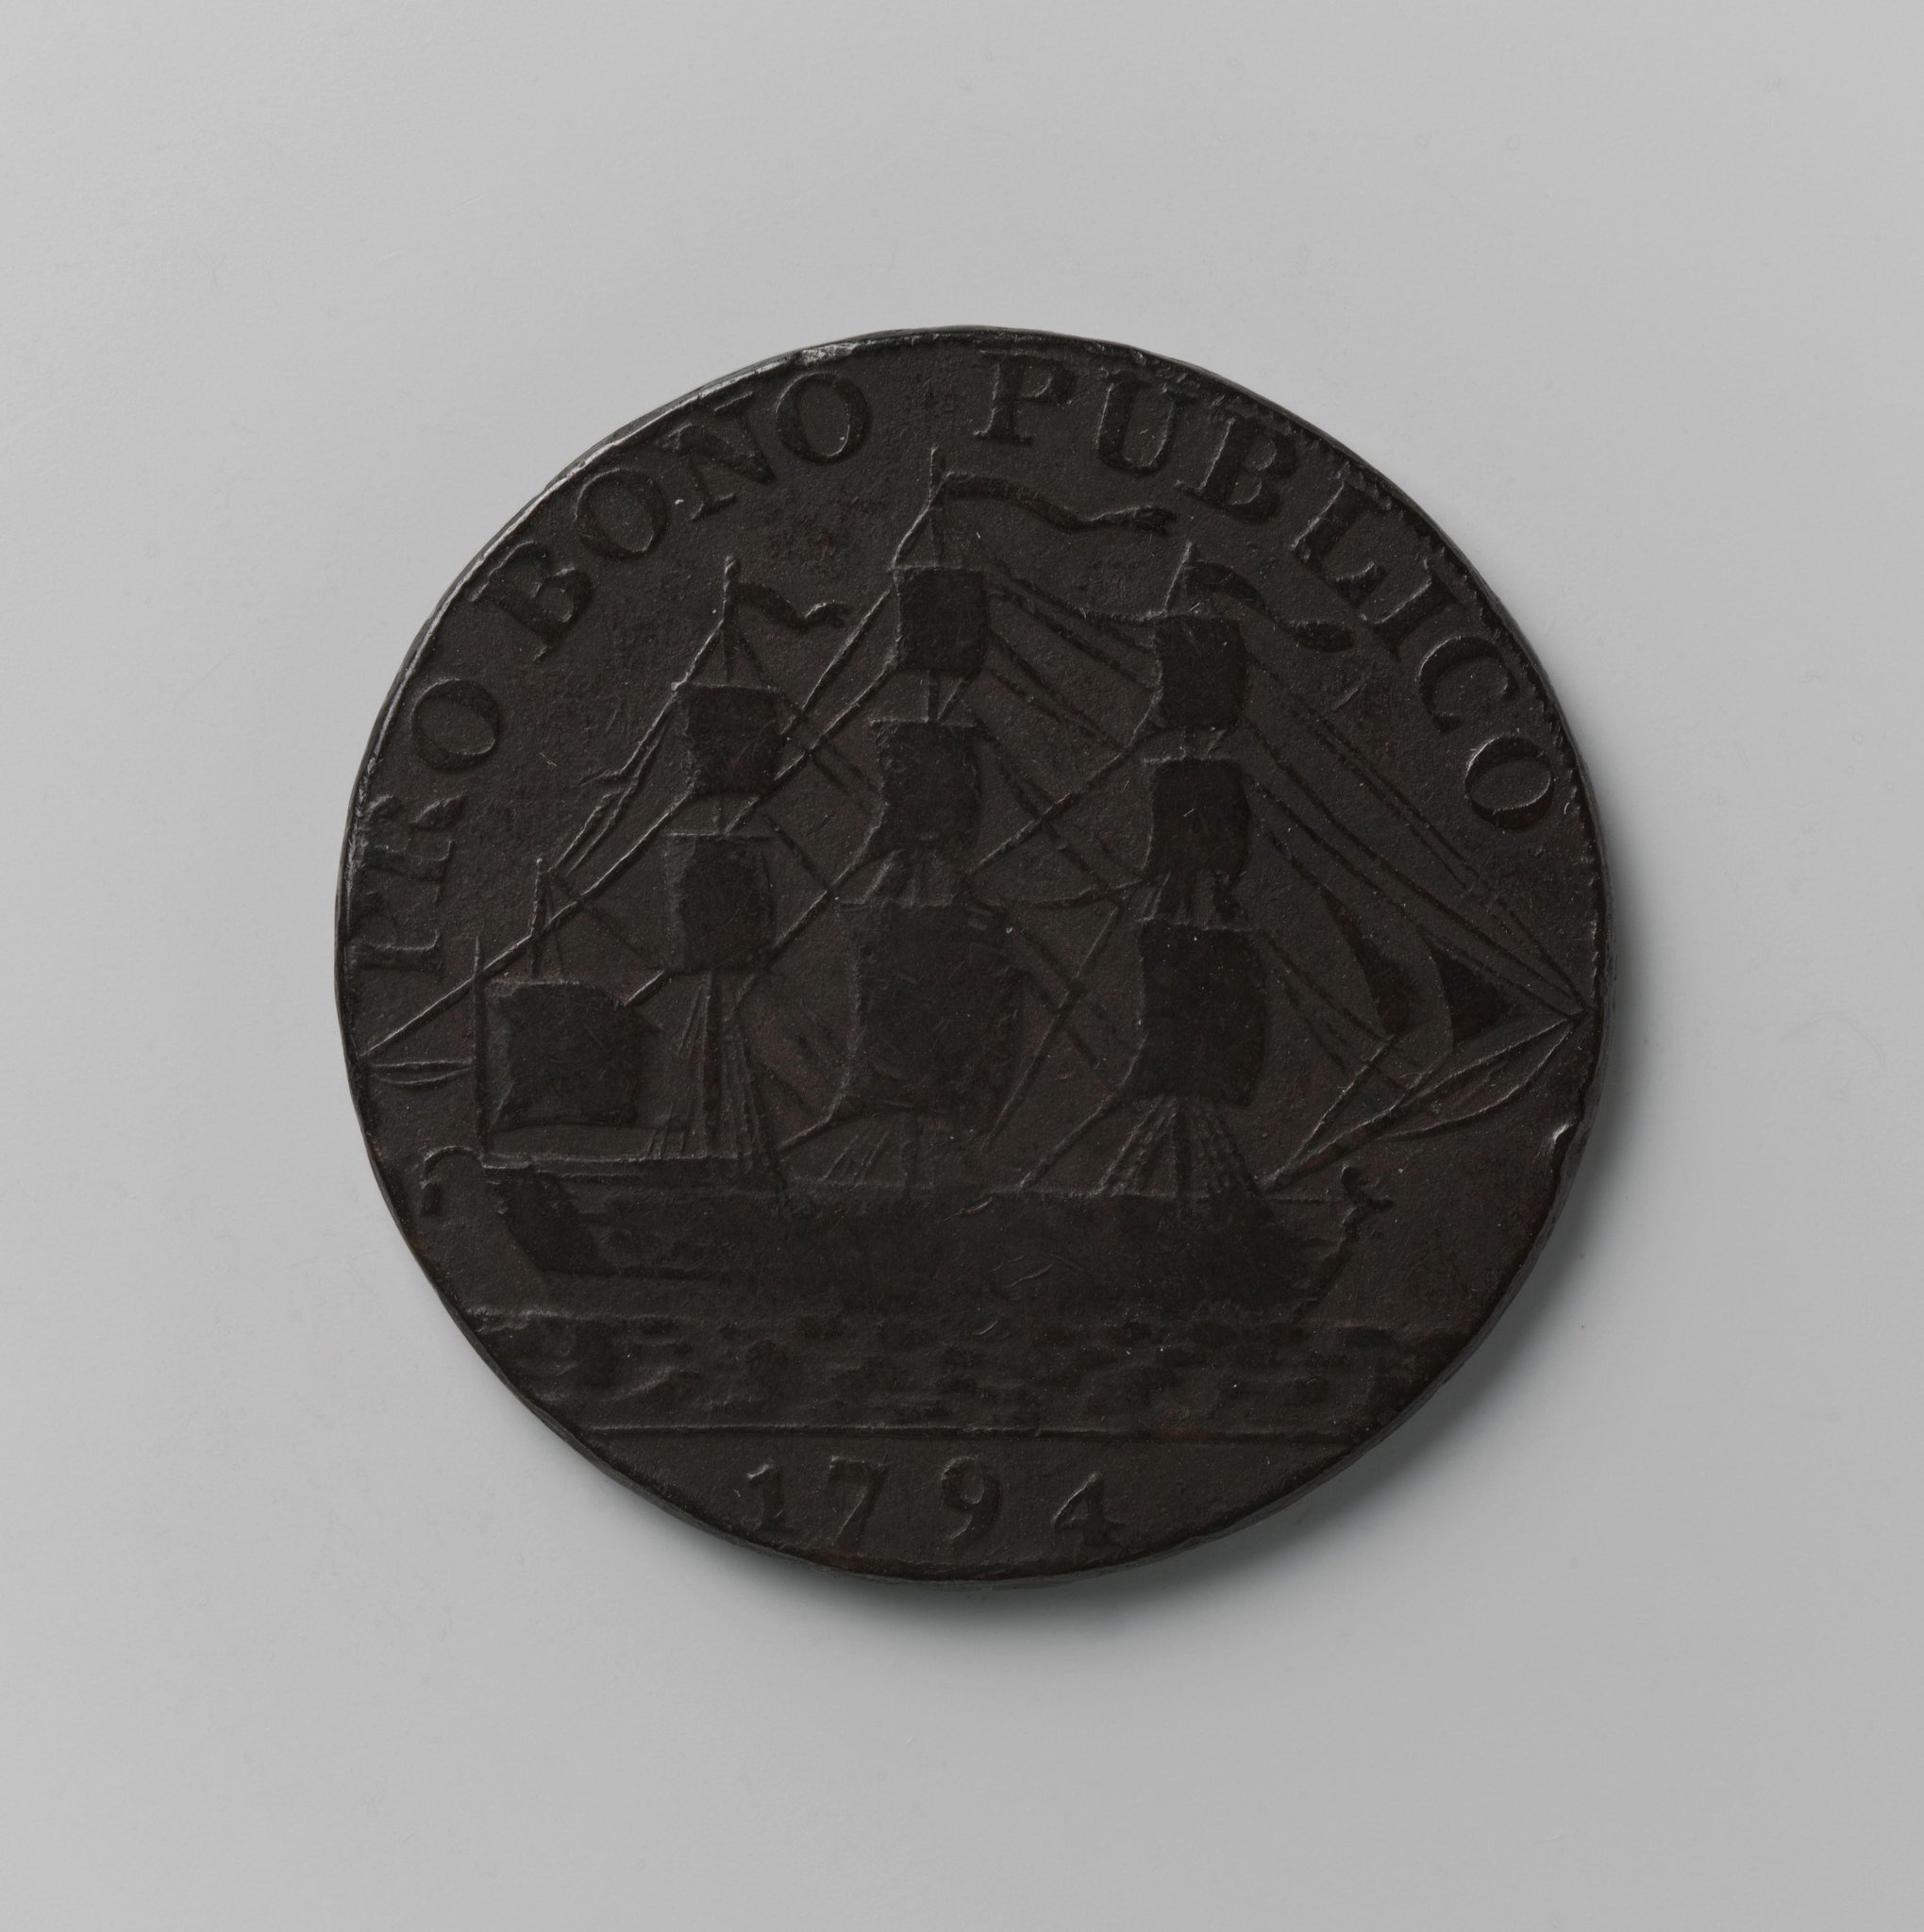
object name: halve penny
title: halve penny, betaalpenning, Gosport, Engeland, 1794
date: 1794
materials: copper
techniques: striking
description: Koperen particuliere munt. Voorzijde: schip met volle zeilen op zee. Jaartal in afsnede. Keerzijde: gehelmde man met lauwerkrans naar links. Randschrift.